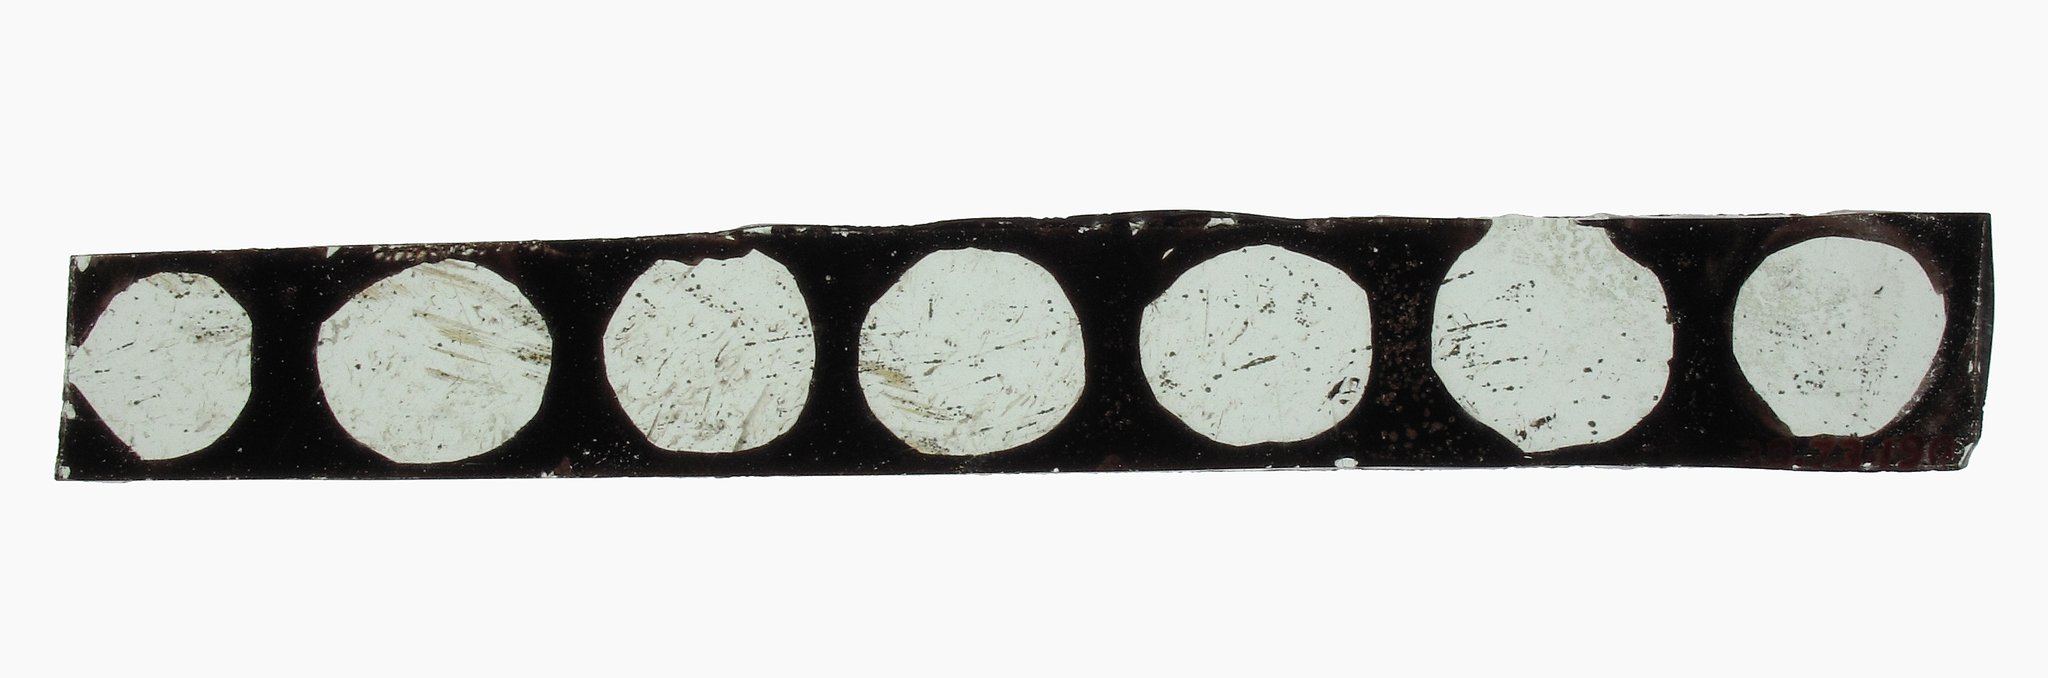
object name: fragment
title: Glass Fragment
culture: european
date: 1401-1500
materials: glass